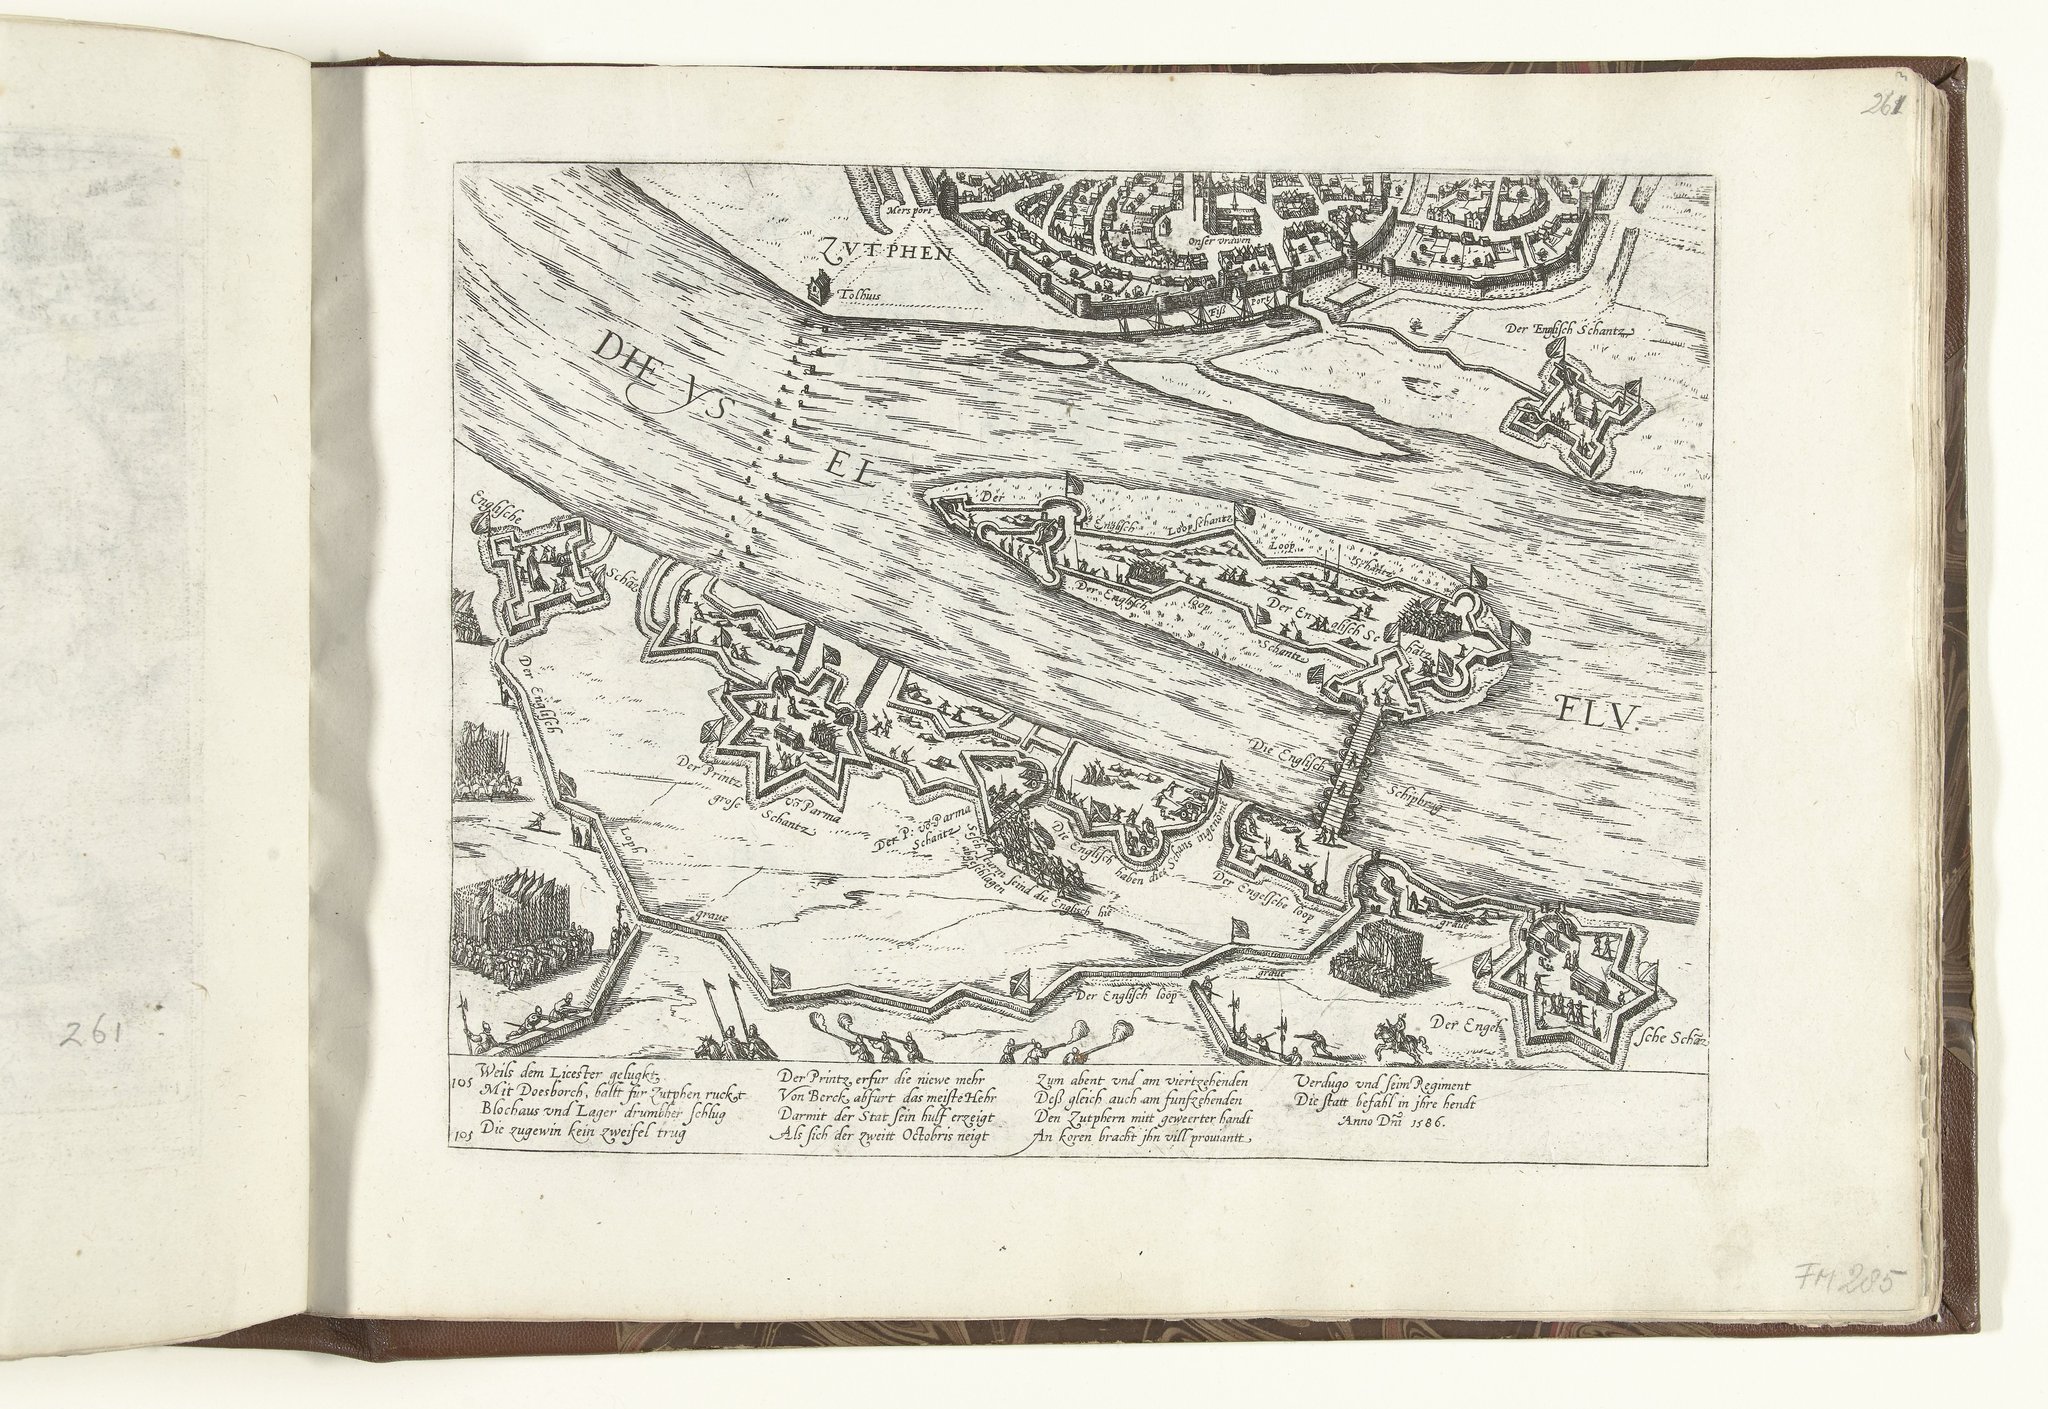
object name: album leaf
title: Beleg van Zutphen door Leicester, 1586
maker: frans hogenberg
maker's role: print maker, publisher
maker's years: 1538-1590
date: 1586-1588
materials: paper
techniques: etching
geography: cologne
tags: rome, alessandro farnese (landvoogd van de nederlanden en hertog van parma en piacenza), robert dudley (1st earl of leicester), siege, position war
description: Beleg van Zutphen door de troepen van de graaf van Leicester, september en oktober 1586. Gezicht op Zutphen en de Engelse en Spaanse schansen langs de IJssel. Met onderschrift van 14 regels in het Duits. Genummerd: 105.